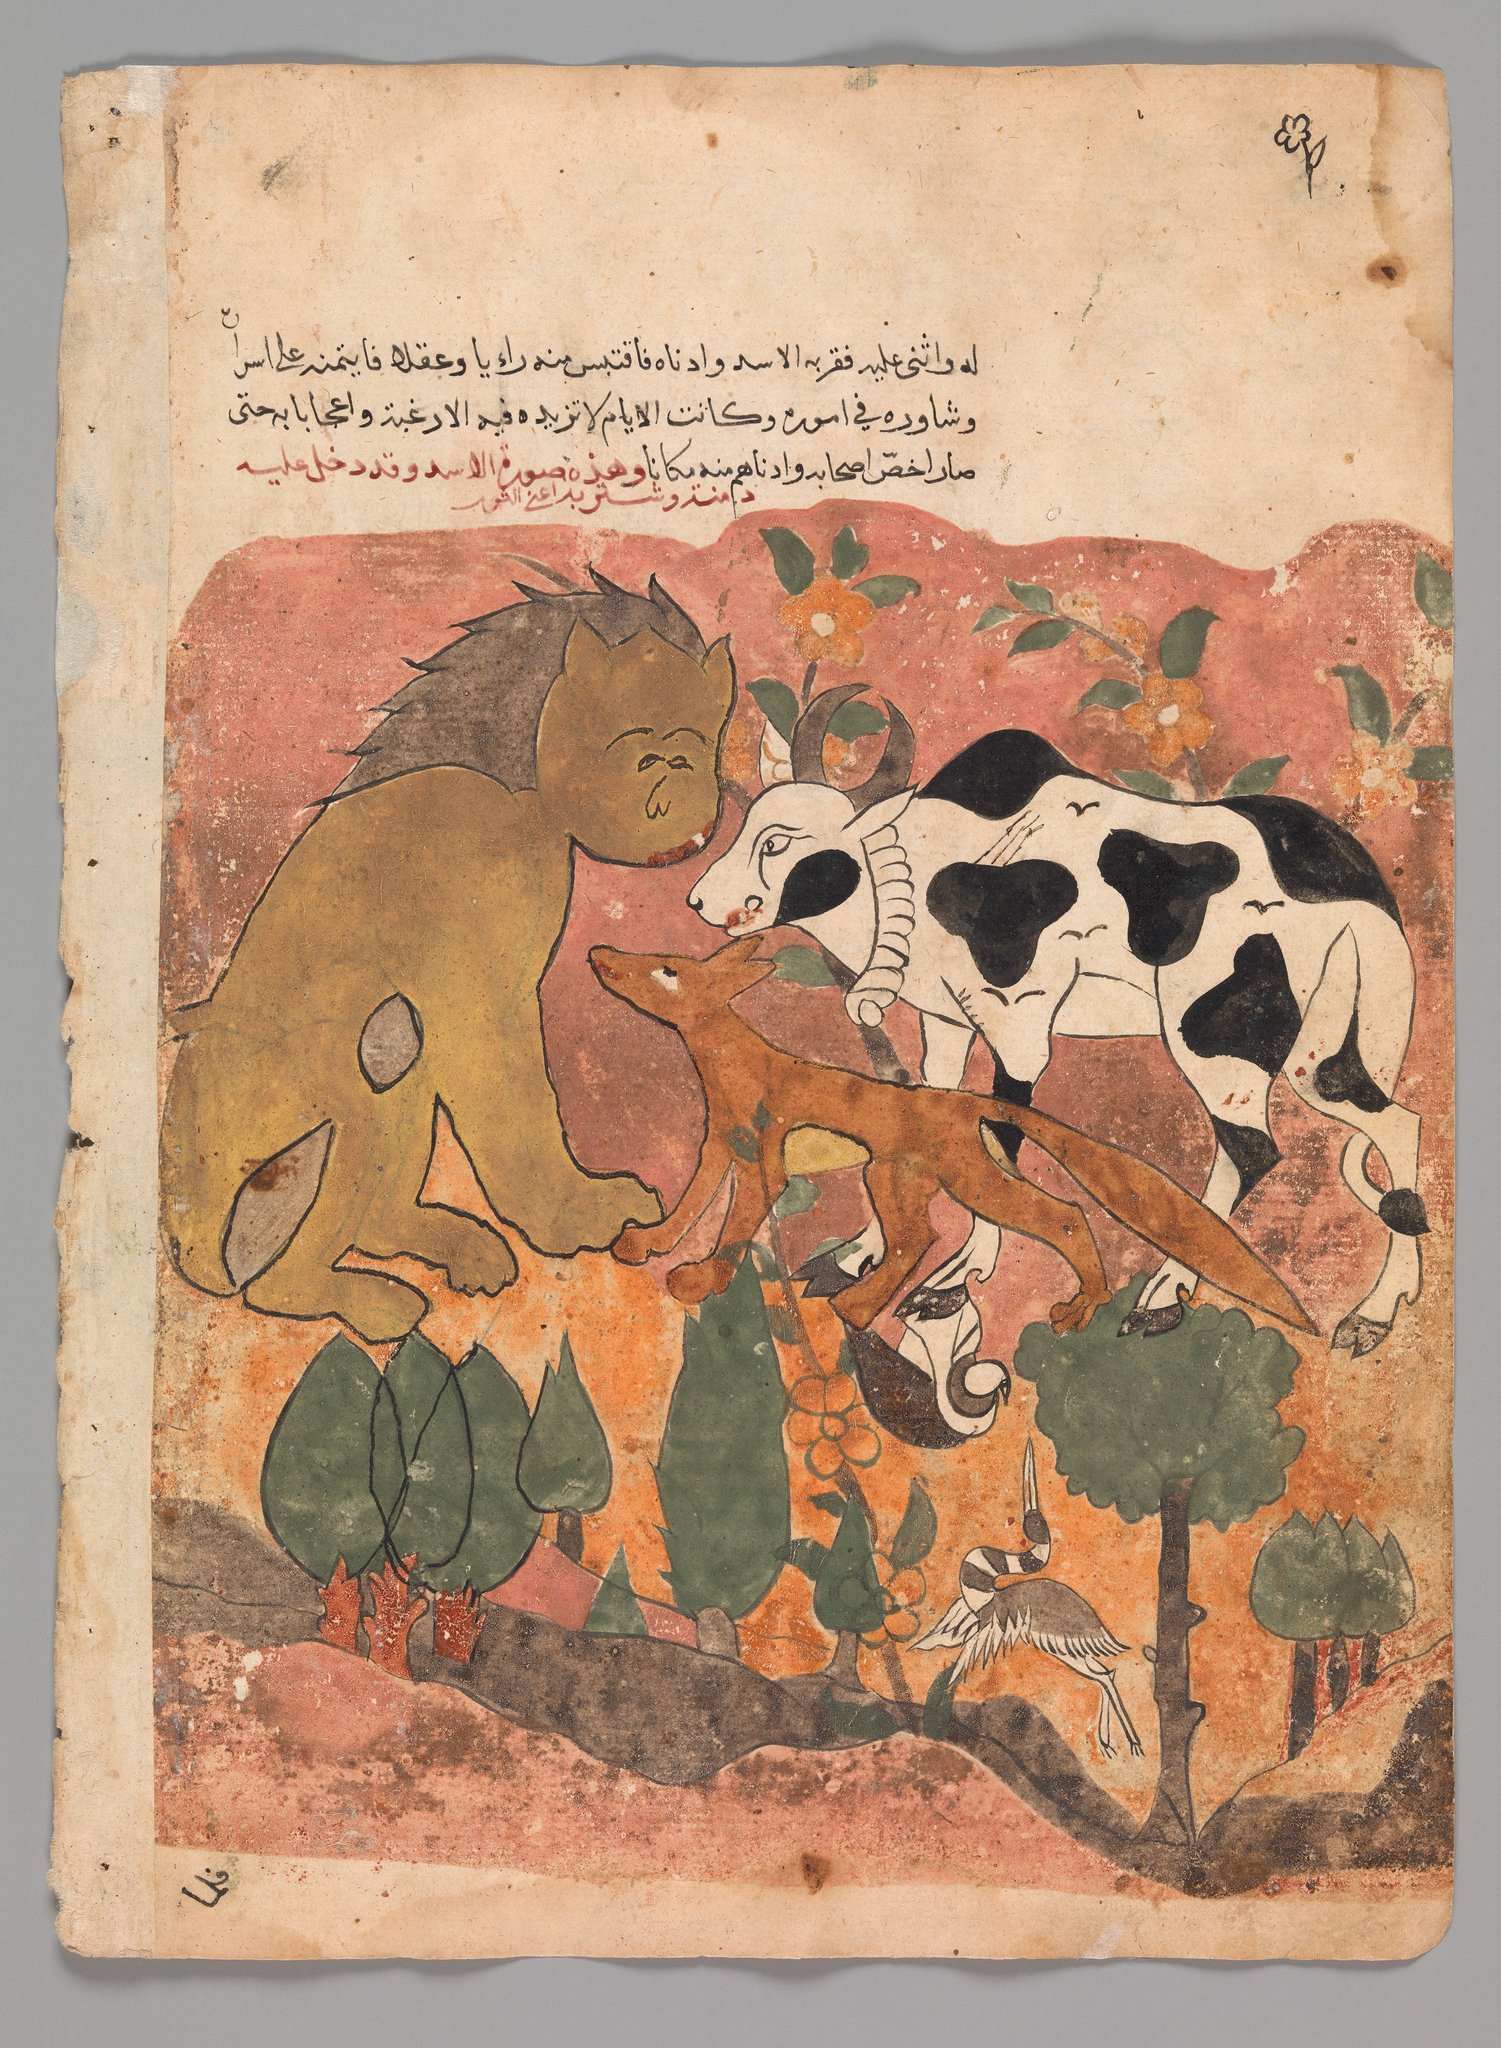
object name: folio from an illustrated manuscript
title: "The Lion King Receives the Ox, Shanzabeh, Escorted by Dimna", Folio from a Kalila wa Dimna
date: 1526-1550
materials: ink, paper, watercolor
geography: india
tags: lions